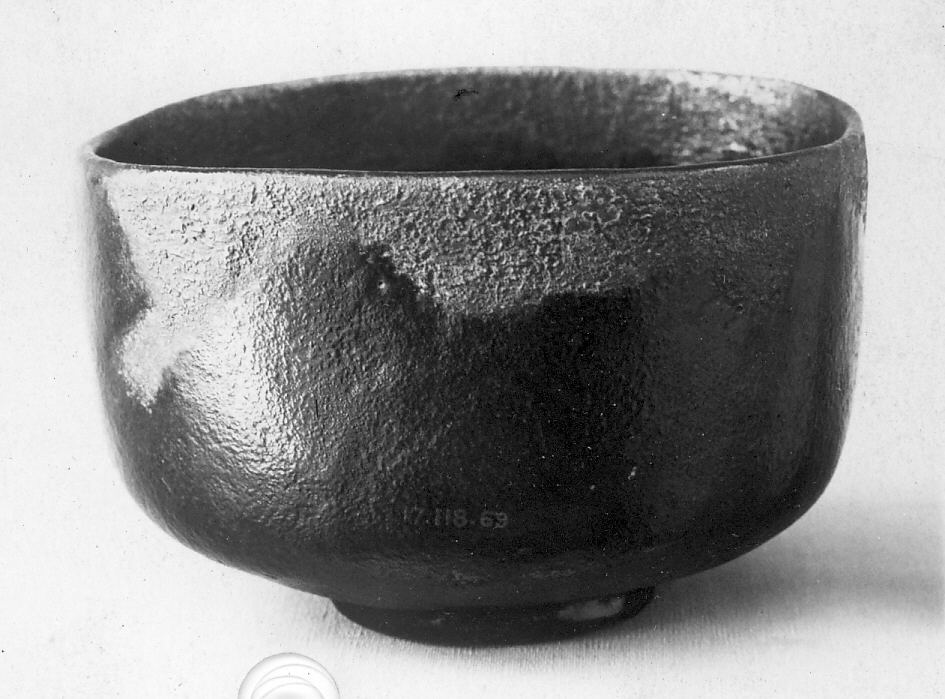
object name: teabowl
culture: japanese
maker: tokunyu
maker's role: artist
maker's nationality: japanese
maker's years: 1675-1775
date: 1770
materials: clay, glaze